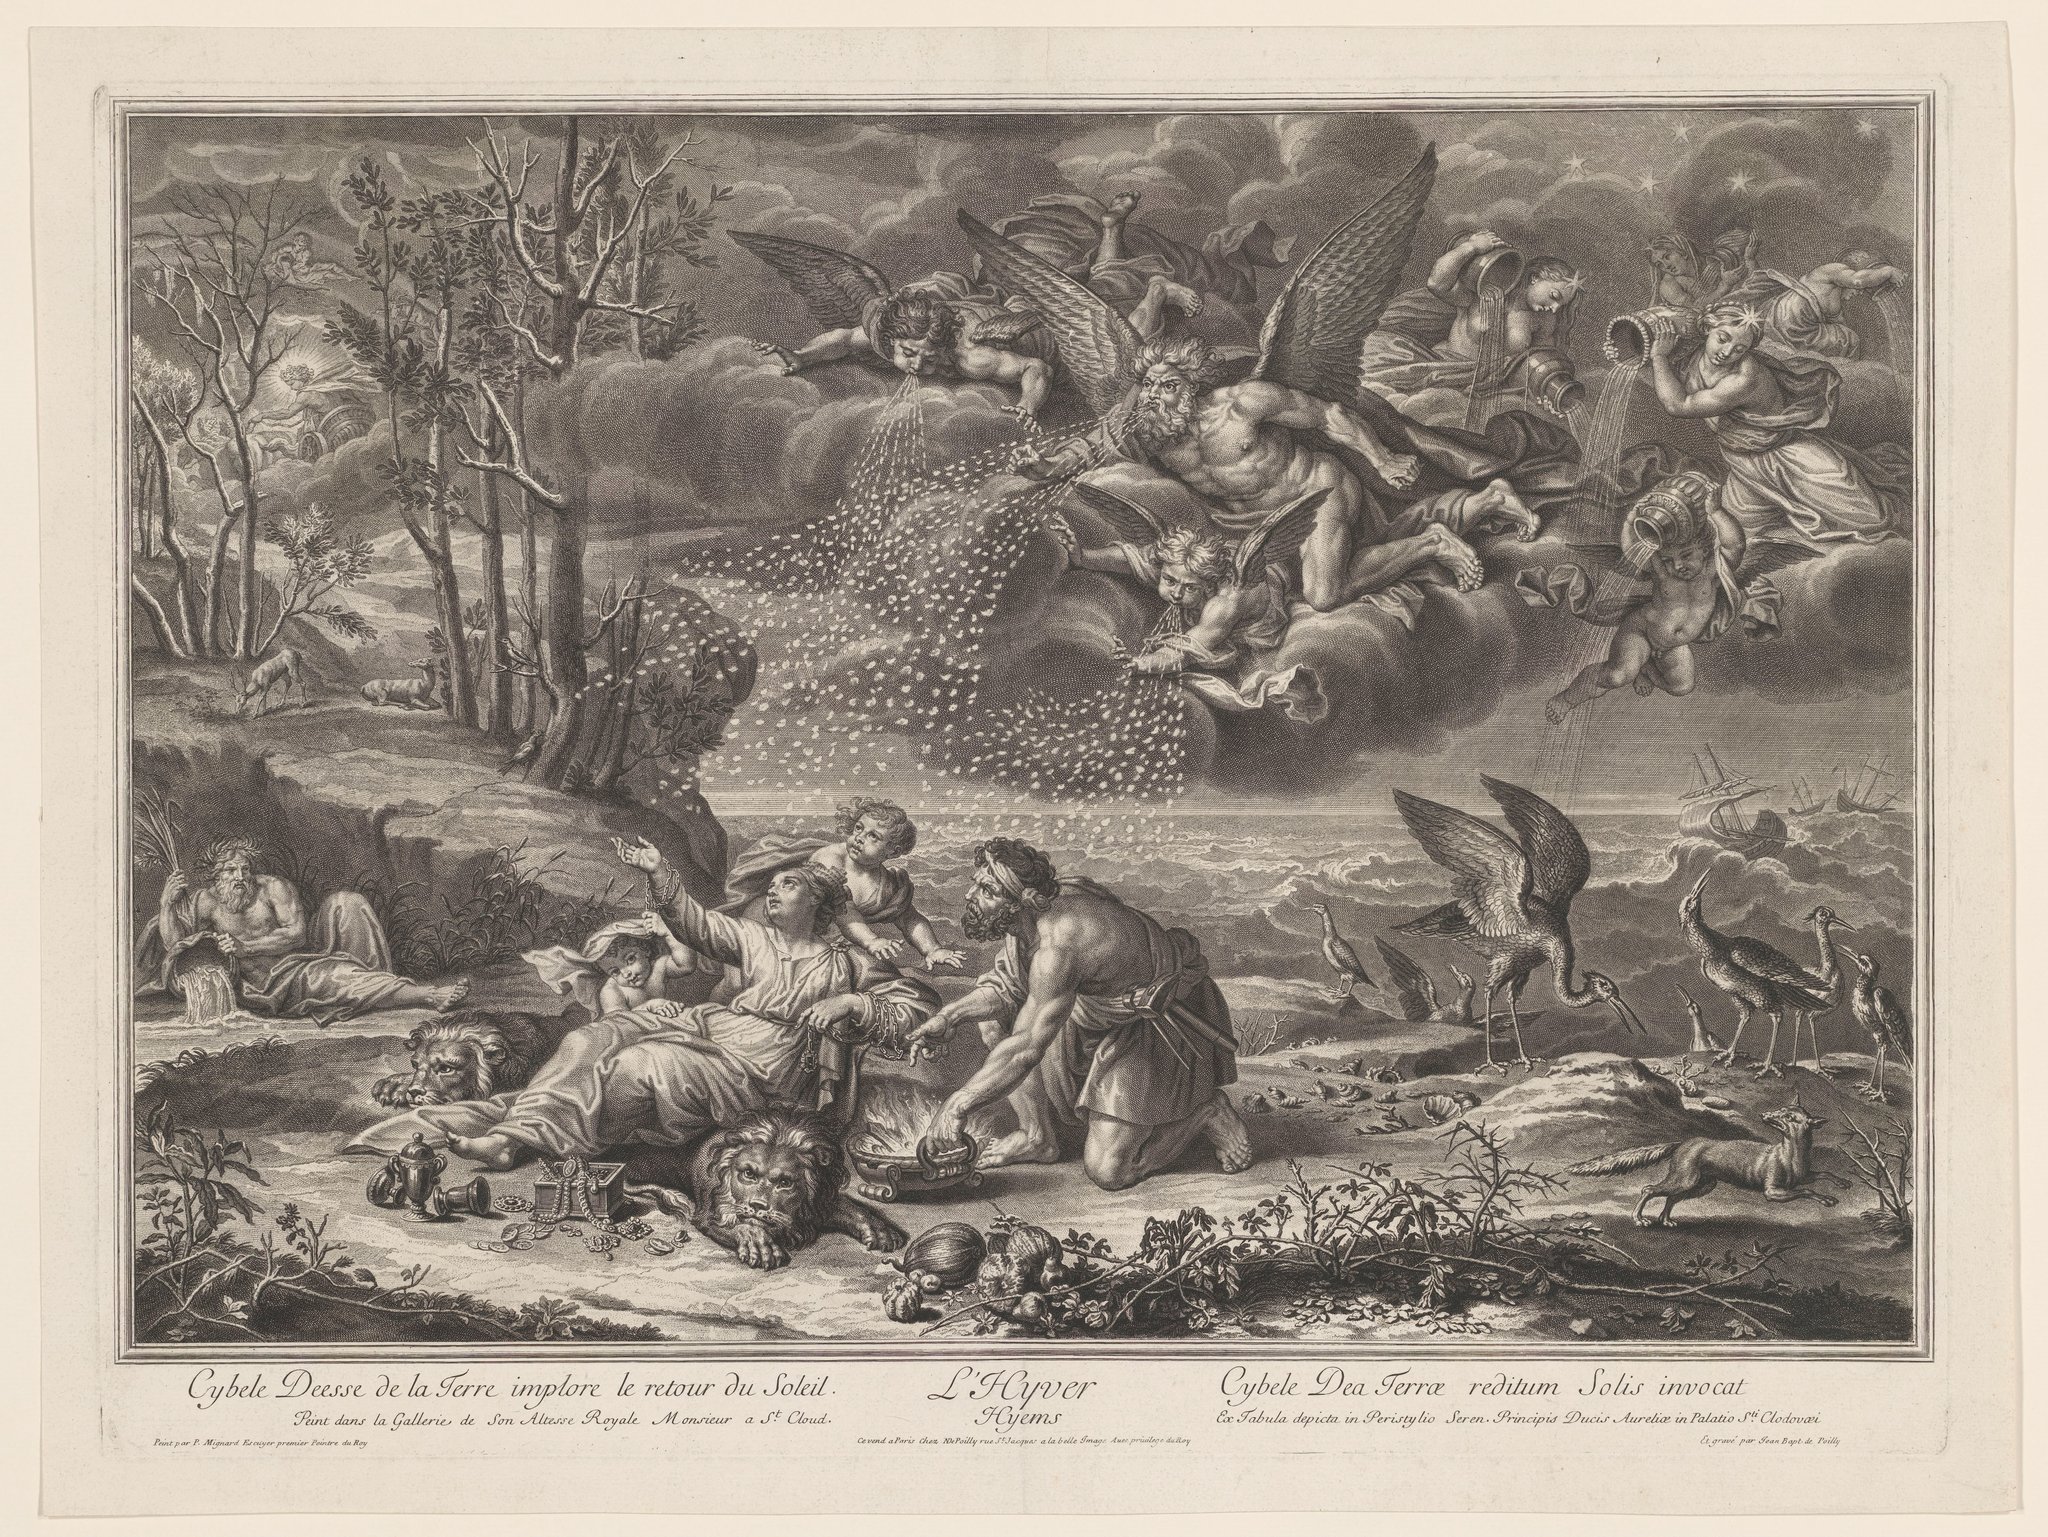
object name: print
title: Hyems. Cybele dea terrae reditum solis invocat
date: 1679-1728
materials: paper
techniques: etching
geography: paris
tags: (story of) cybele, rhea cybele, great mother of the gods (berecynt(h)ia), winter landscape; landscape symbolizing winter (the four seasons of the year)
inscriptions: collector's mark: Lugt 240